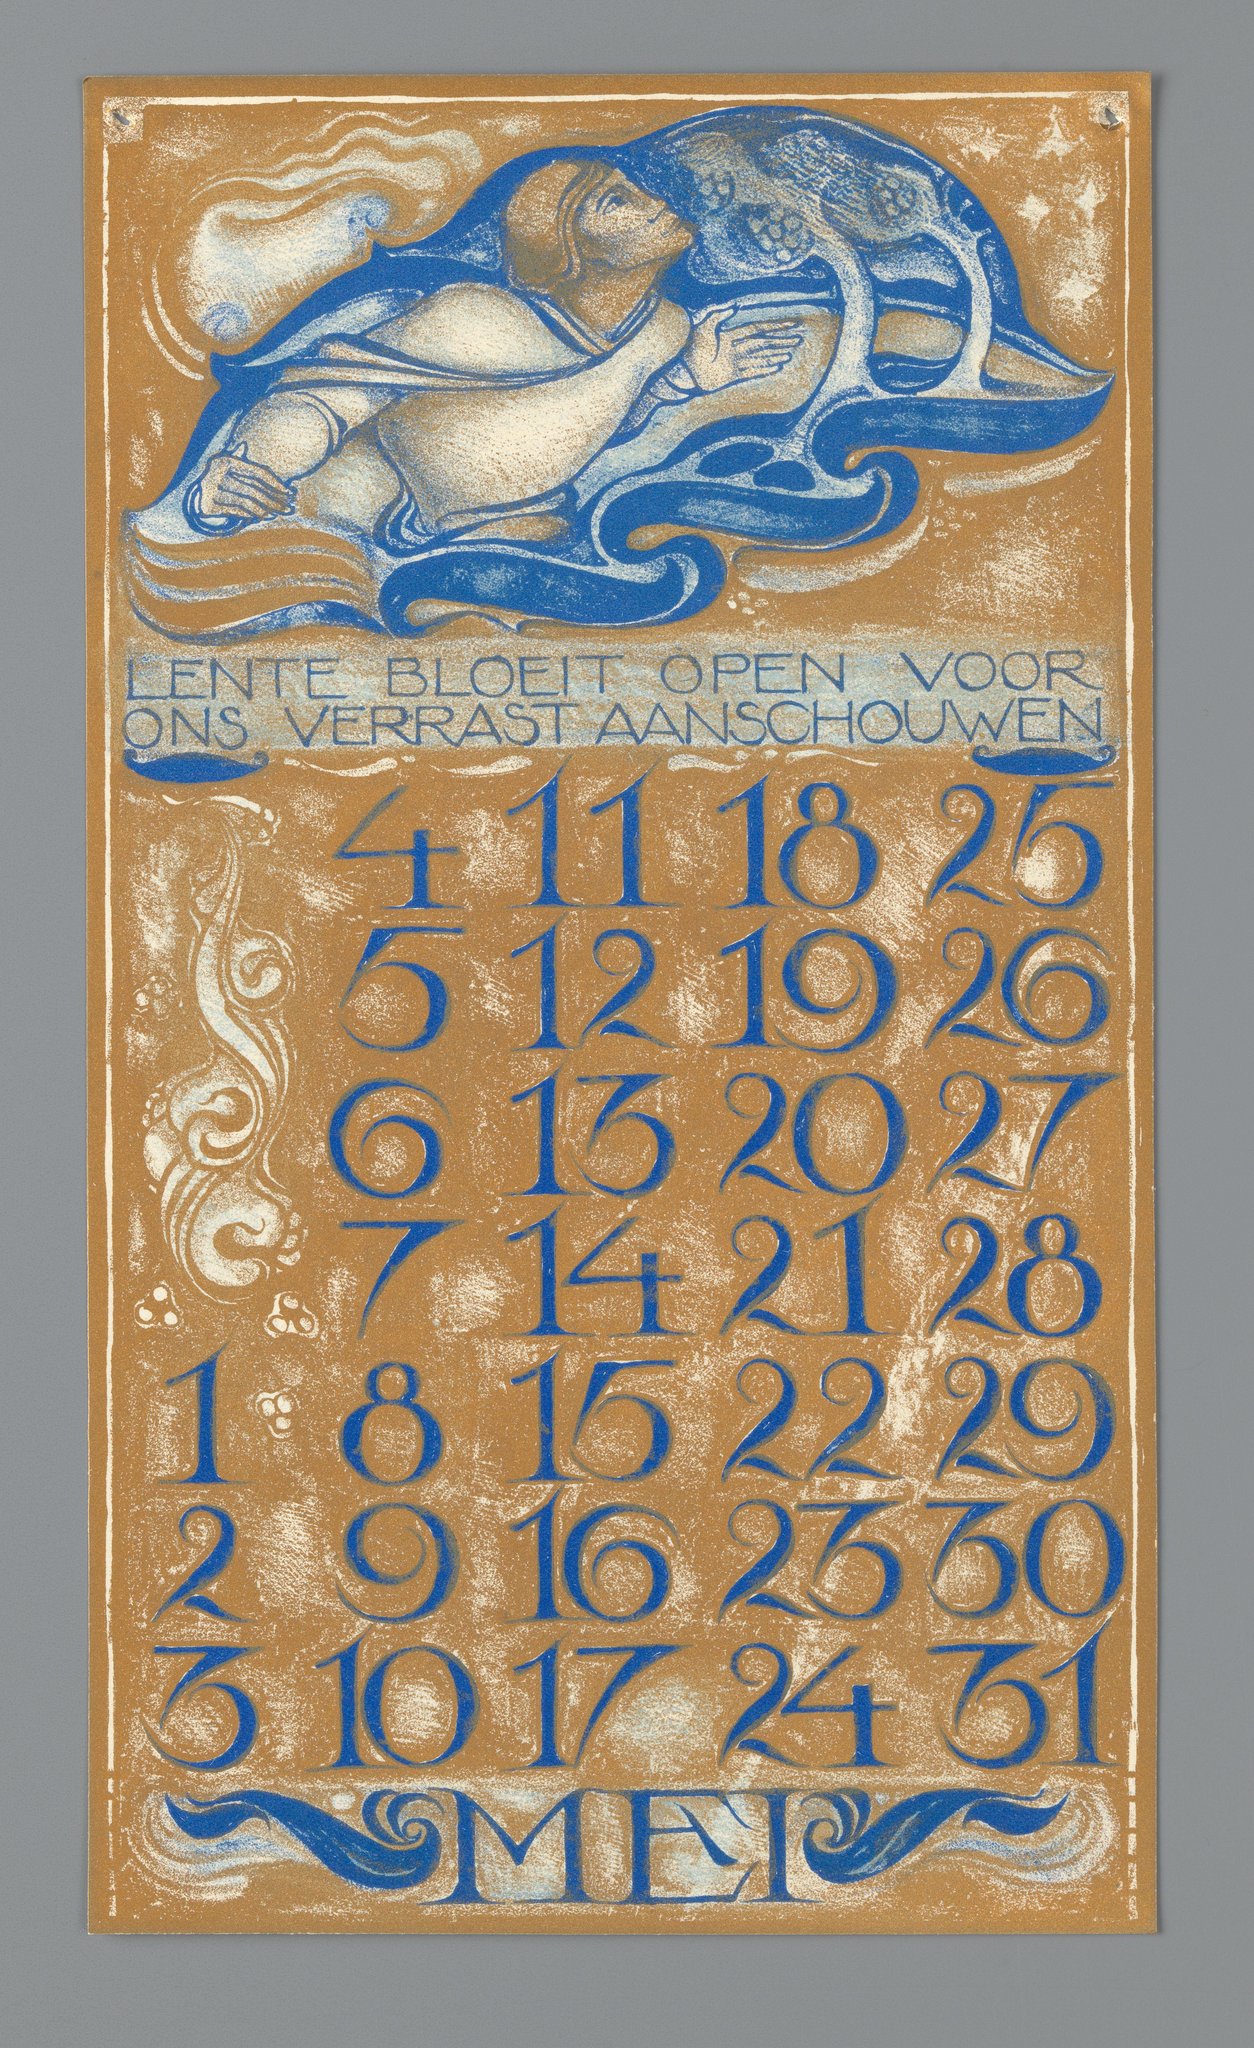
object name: print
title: Kalenderblad voor mei 1930 van de Nederlandsch Kunstverbond Kalender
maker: willem arondéus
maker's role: draughtsman, print maker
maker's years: 1894-1943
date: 1929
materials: paper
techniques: lithograph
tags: flowers, calendar, almanac, adult man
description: Een mannenfiguur bij een bloeiende plant, met de spreuk: 'Lente bloeit open voor ons verrast aanschouwen'. Daaronder de maandcijfers en kleine golvende decoraties.